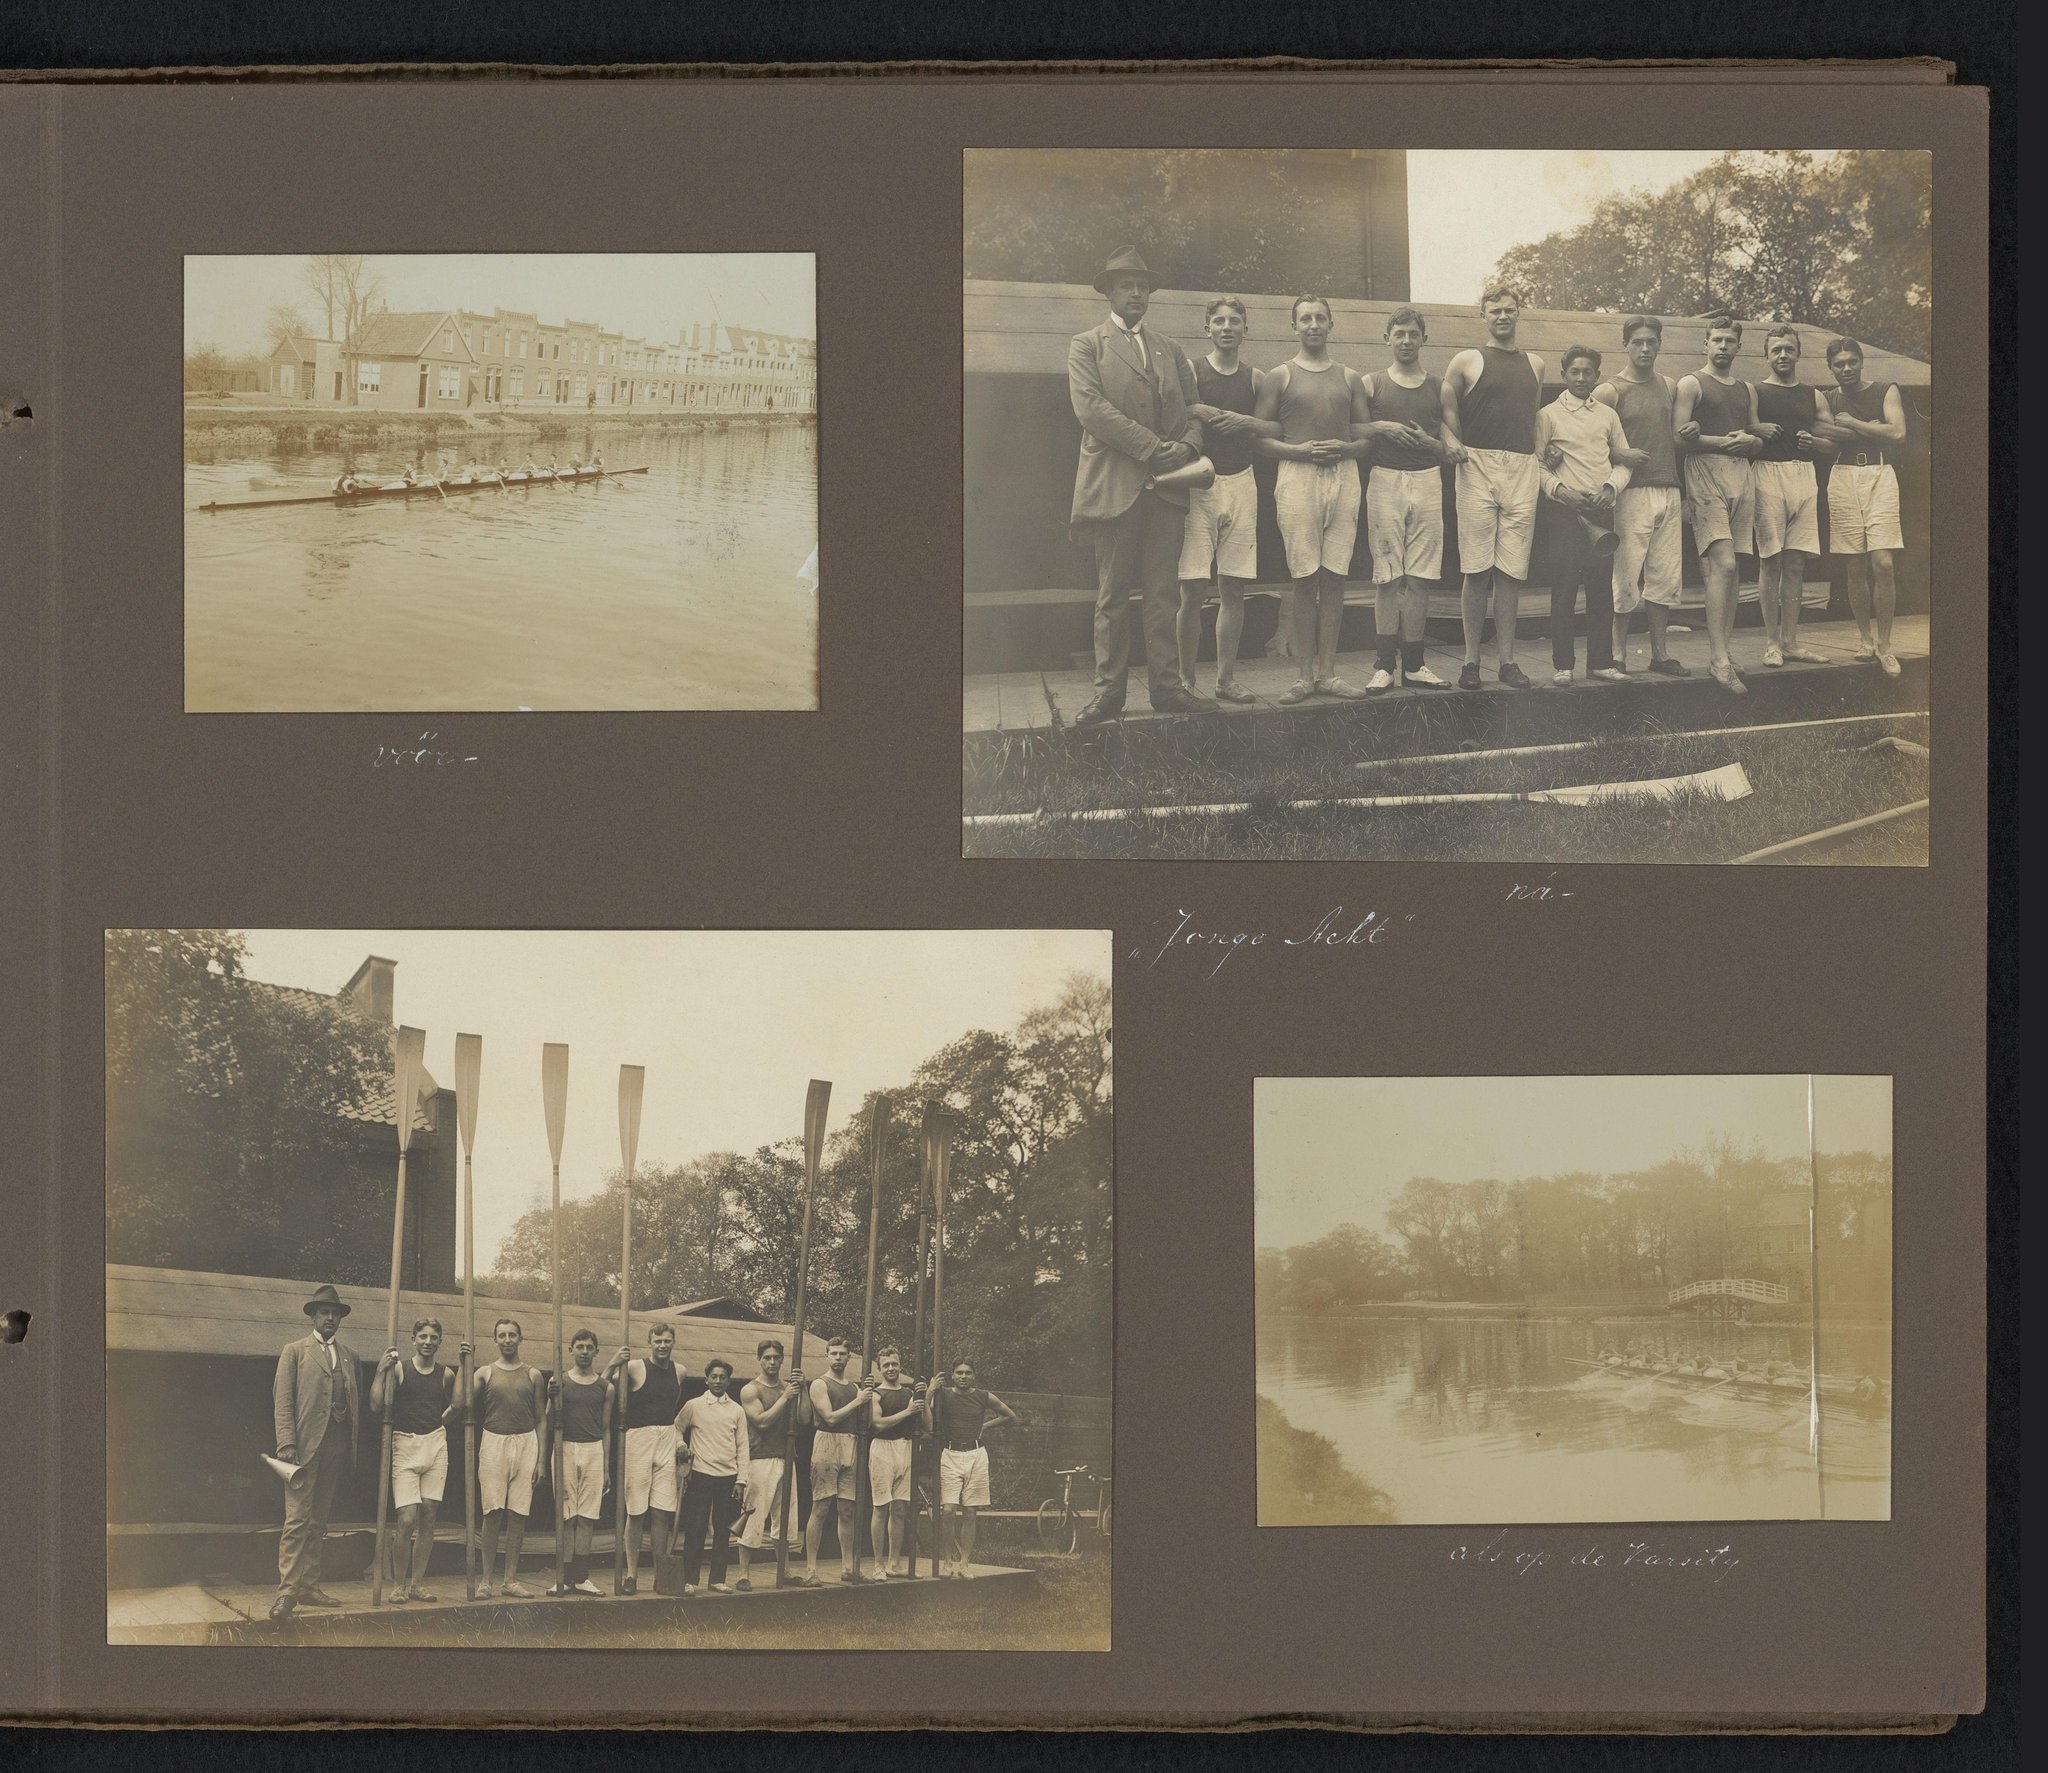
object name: album leaf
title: Jonge Acht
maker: Anonymous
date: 1915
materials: paper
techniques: gelatin silver print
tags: rowing facing backward, pulling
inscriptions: inscription: ‘vóór/ ná/ Als op de Varsity’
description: Deze foto's maken deel uit van een album.